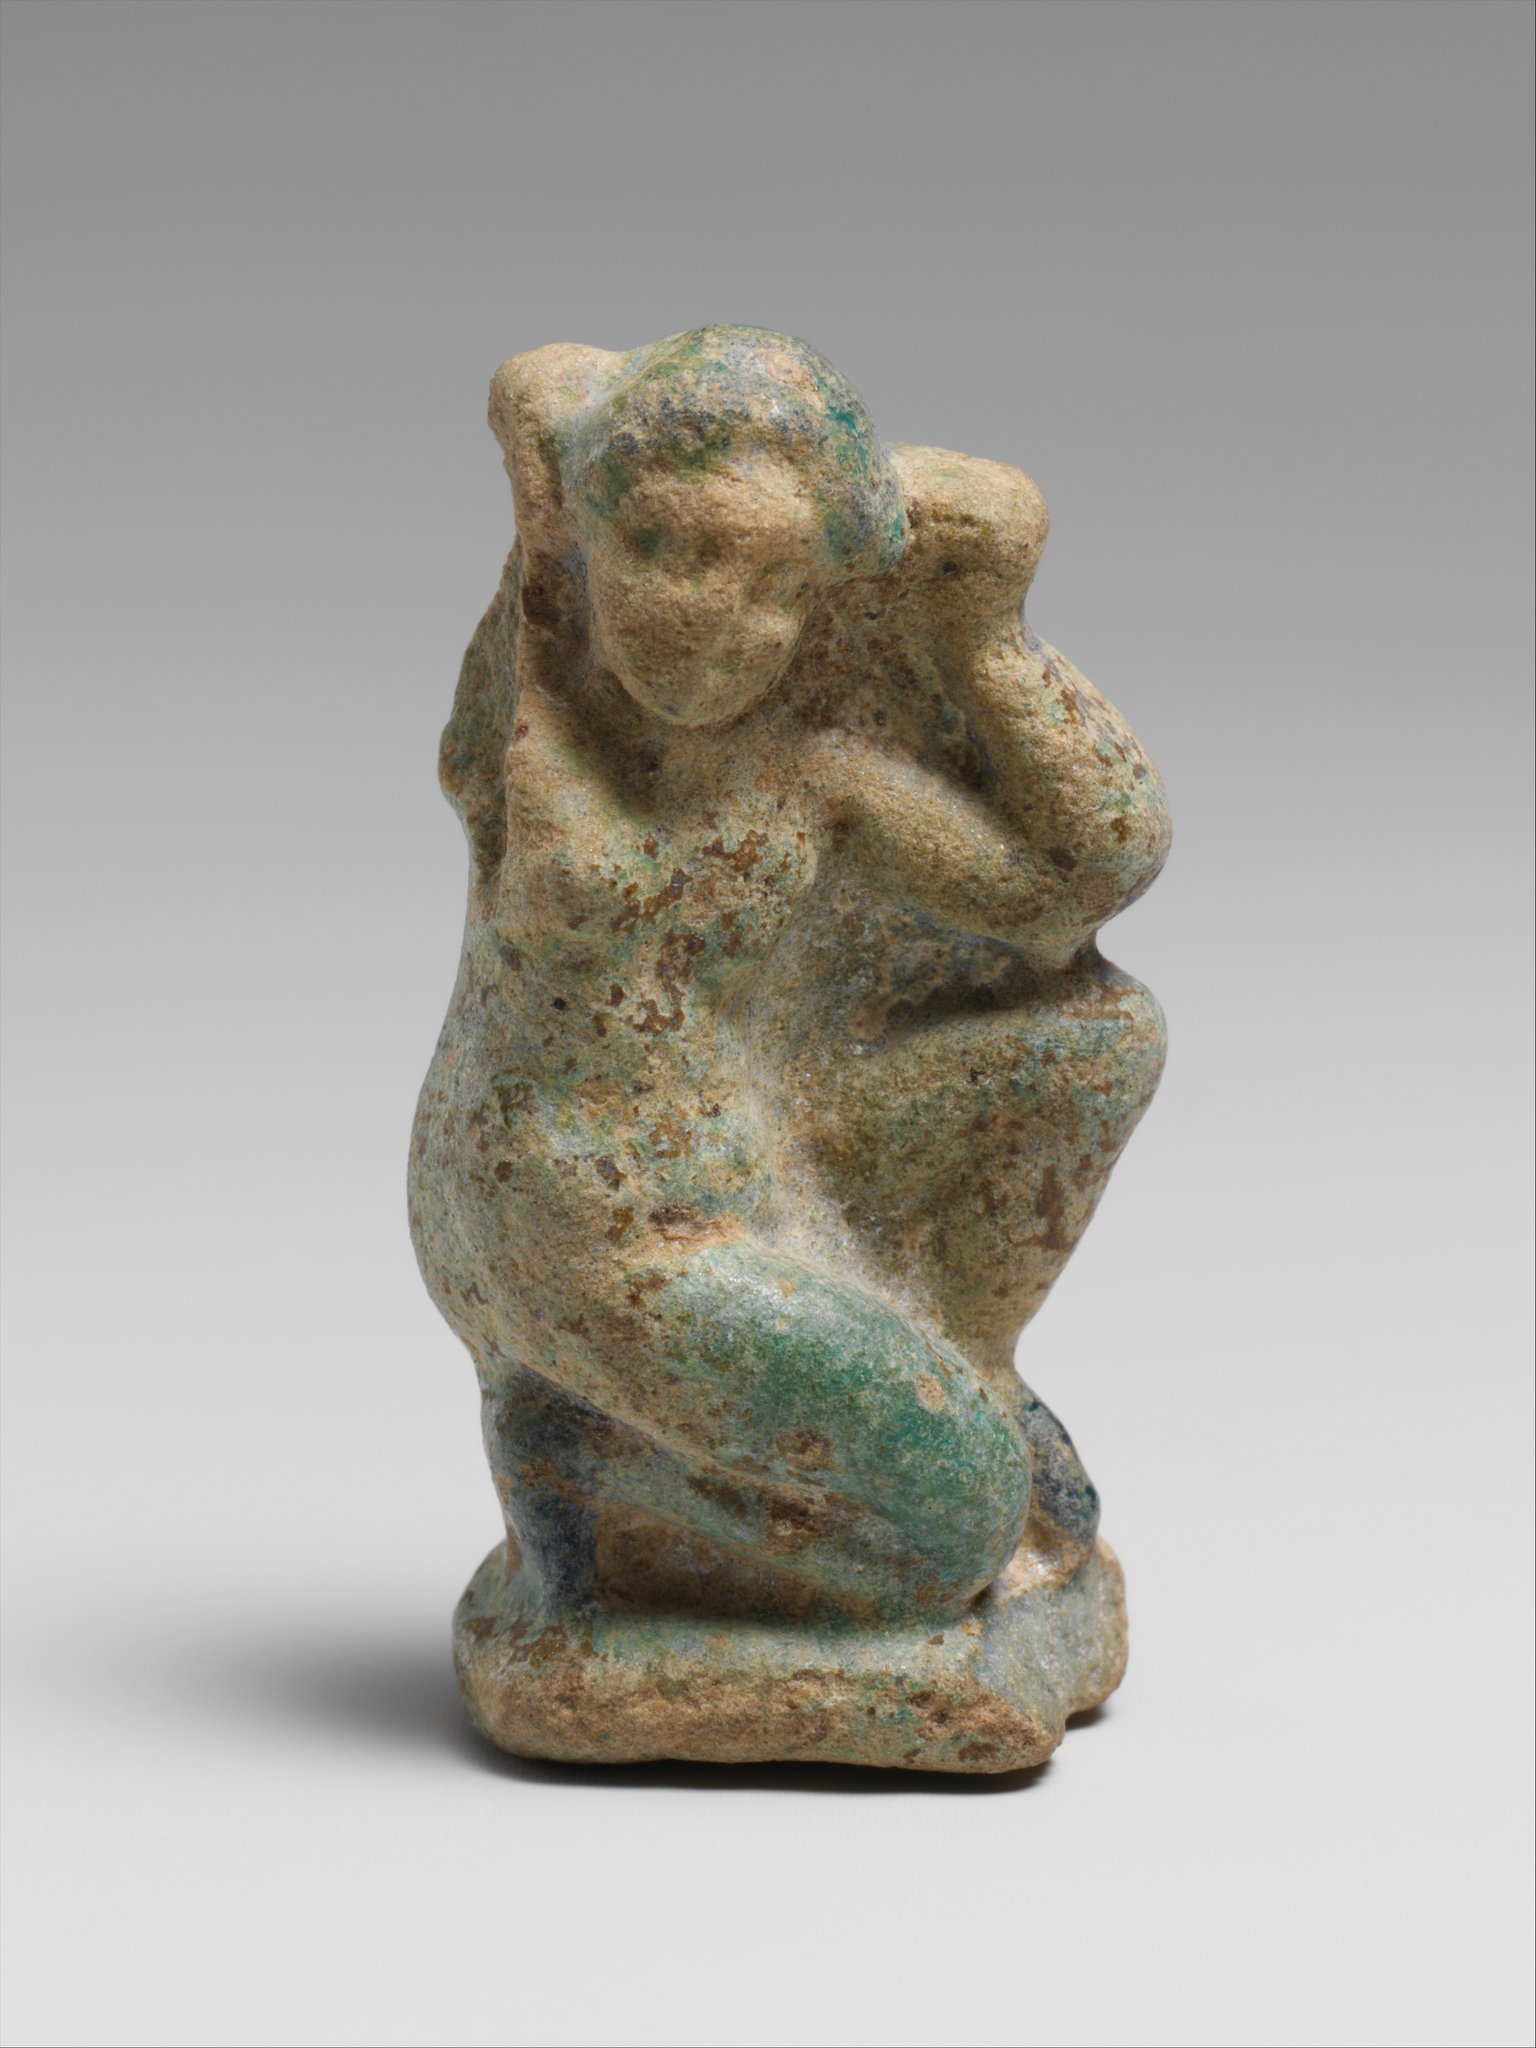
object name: amulet, aphrodite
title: Faience statuette of Aphrodite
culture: egyptian, ptolemaic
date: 334-330 BCE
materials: faience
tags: aphrodite